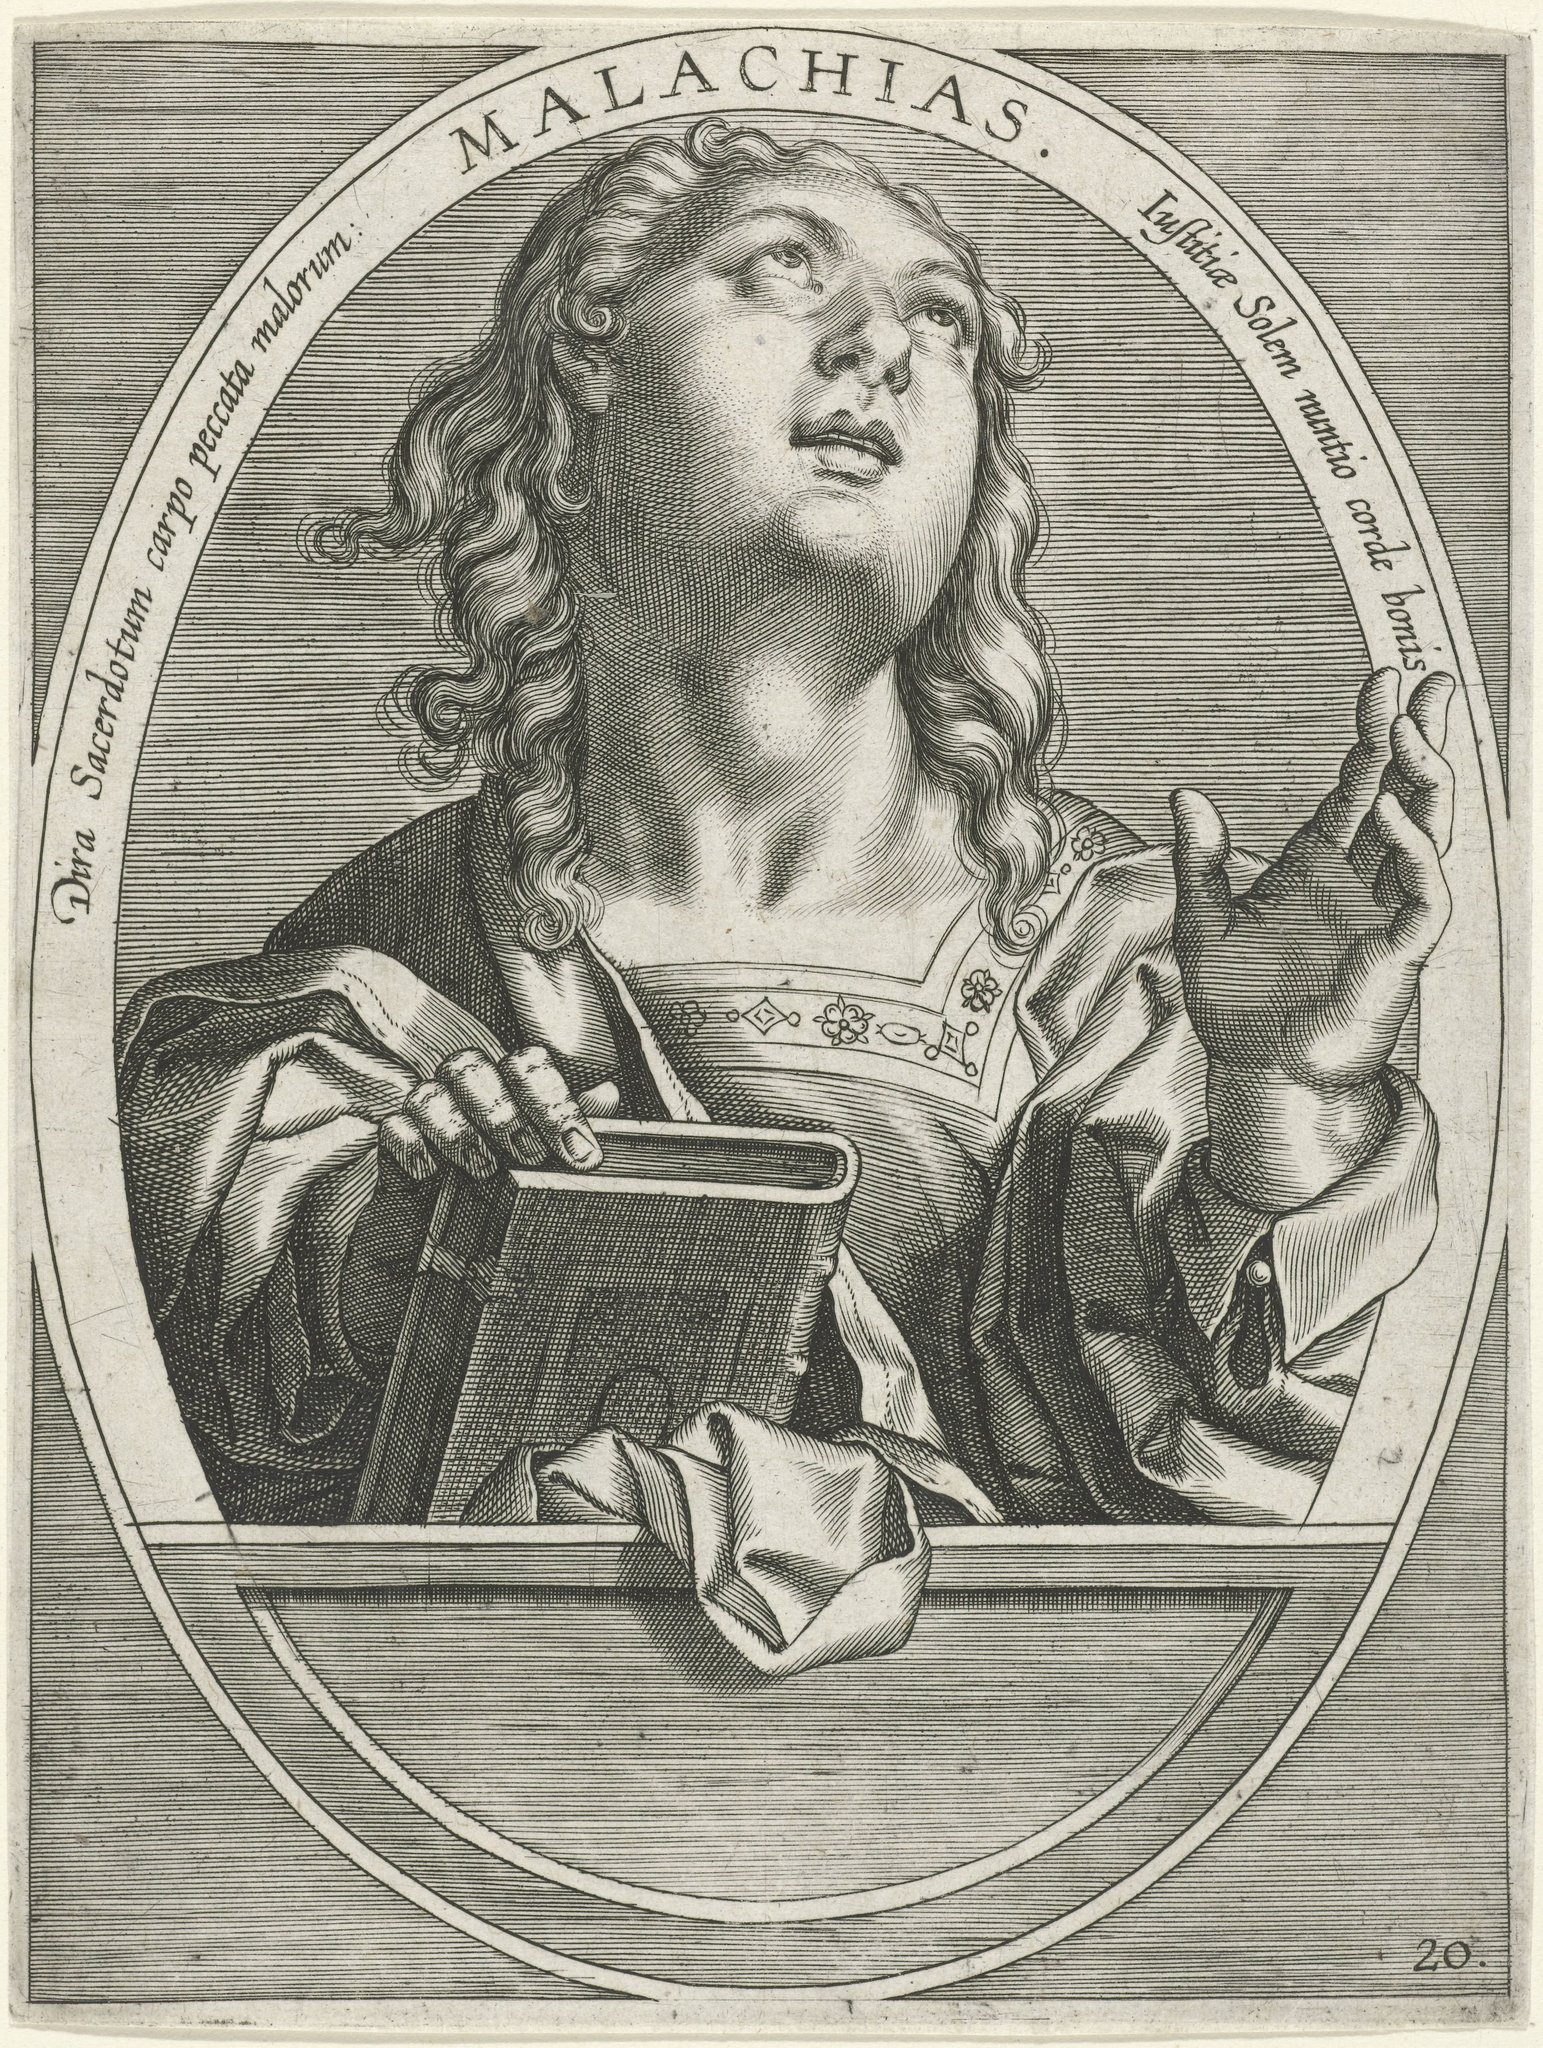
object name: print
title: Icones Prophetarum Veteris Testamenti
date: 1613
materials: paper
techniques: engraving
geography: antwerp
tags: the twelve minor prophets (not in biblical context): hosea, joel, amos, obadiah, jonah, micah, nahum, habakkuk, zephaniah, haggai, zechariah, malachi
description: De profeet Maleachi met een boek in zijn hand, in ovaal met Latijns randschrift.